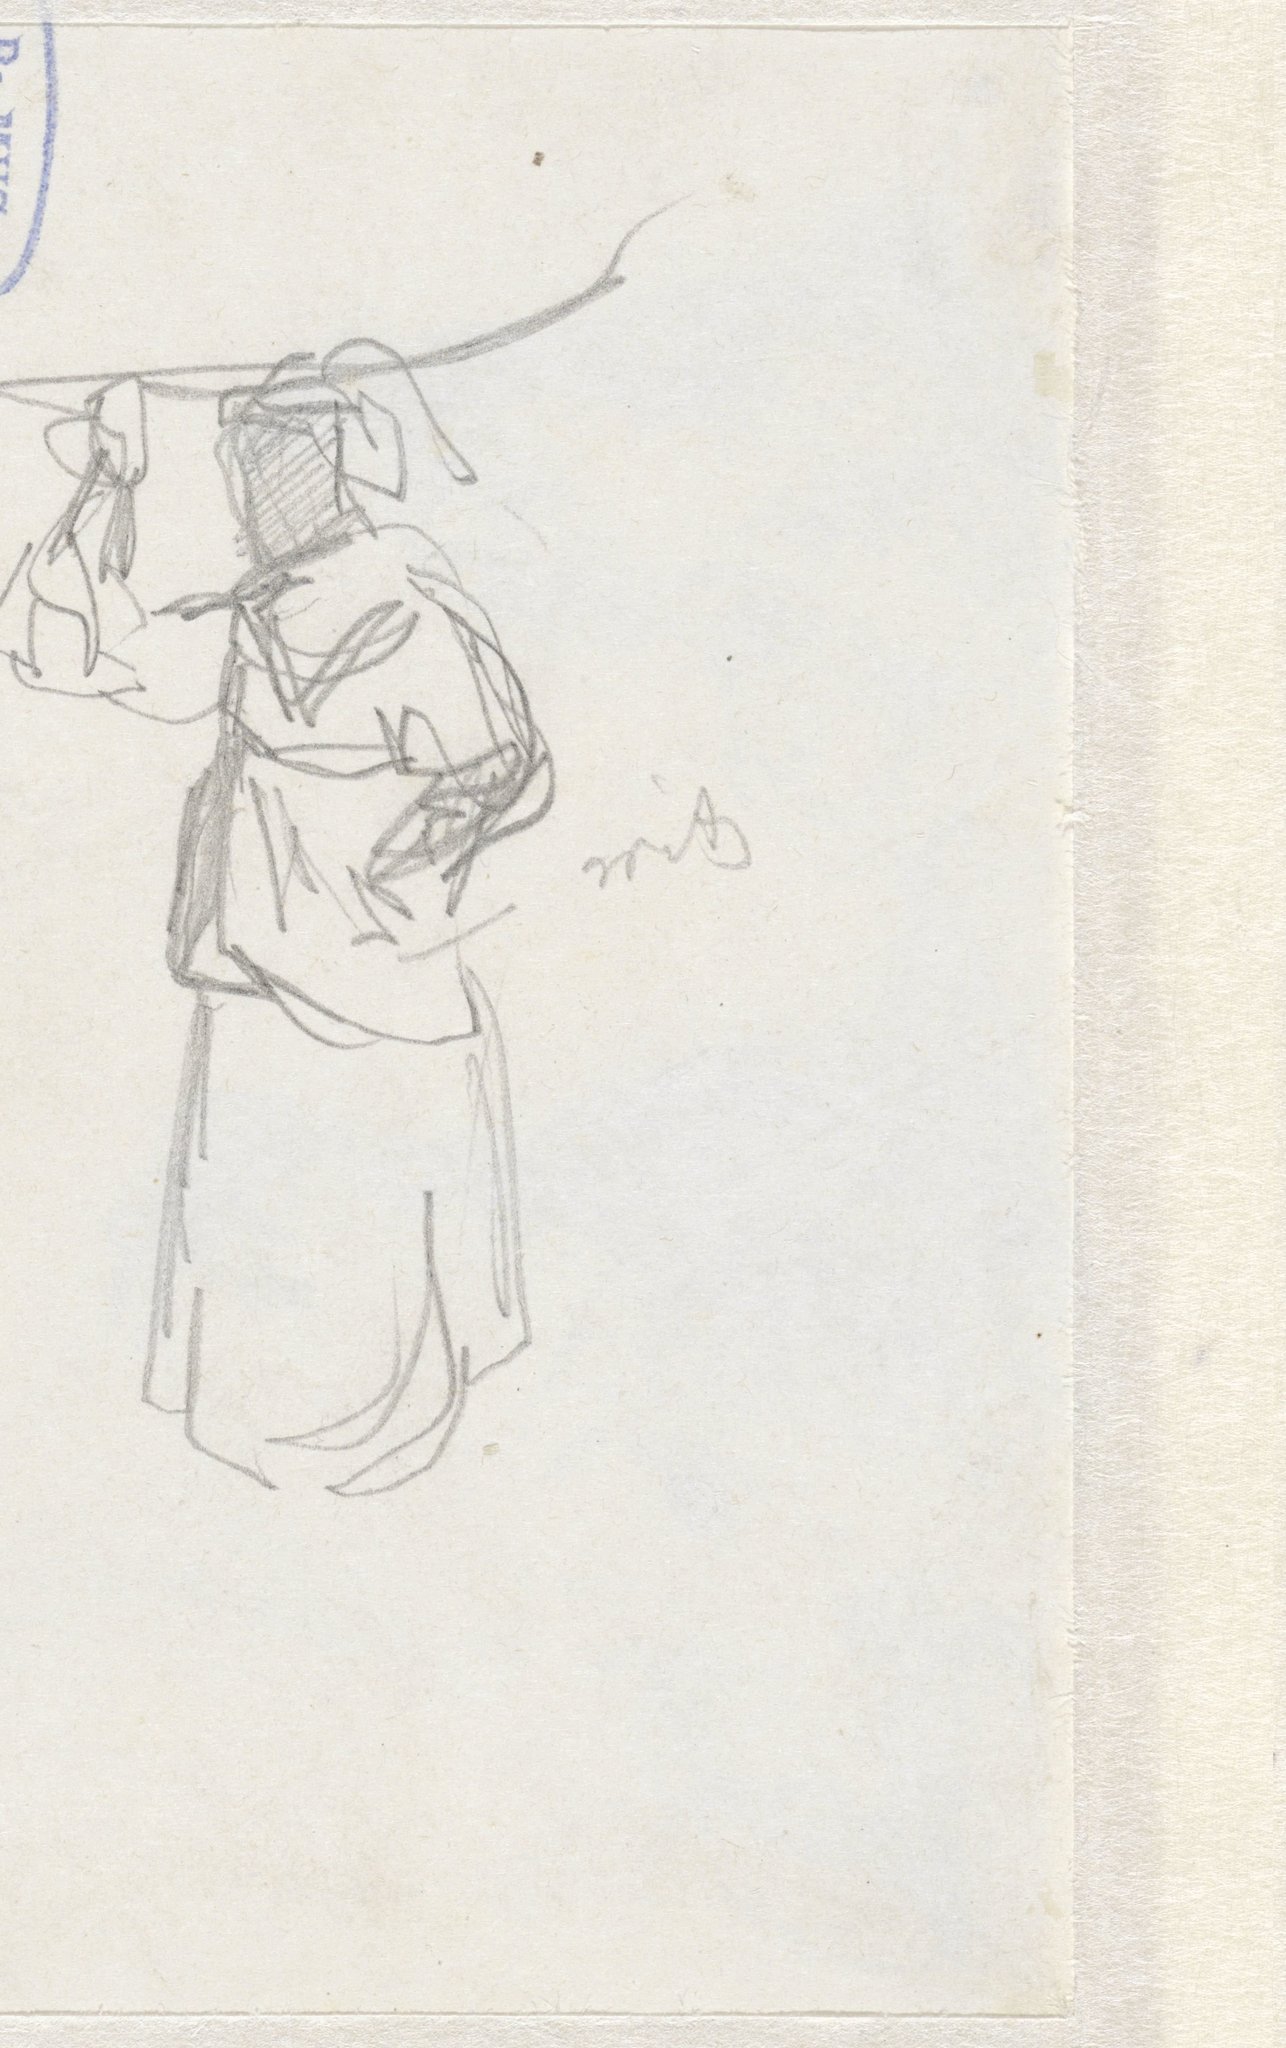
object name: drawing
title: Figuurstudie van een vrouw met een mand op het hoofd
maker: johan daniël koelman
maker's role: draughtsman, print maker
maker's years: 1831-1857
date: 1841-1857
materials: paper, pencil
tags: standing figure - aa - female human figure